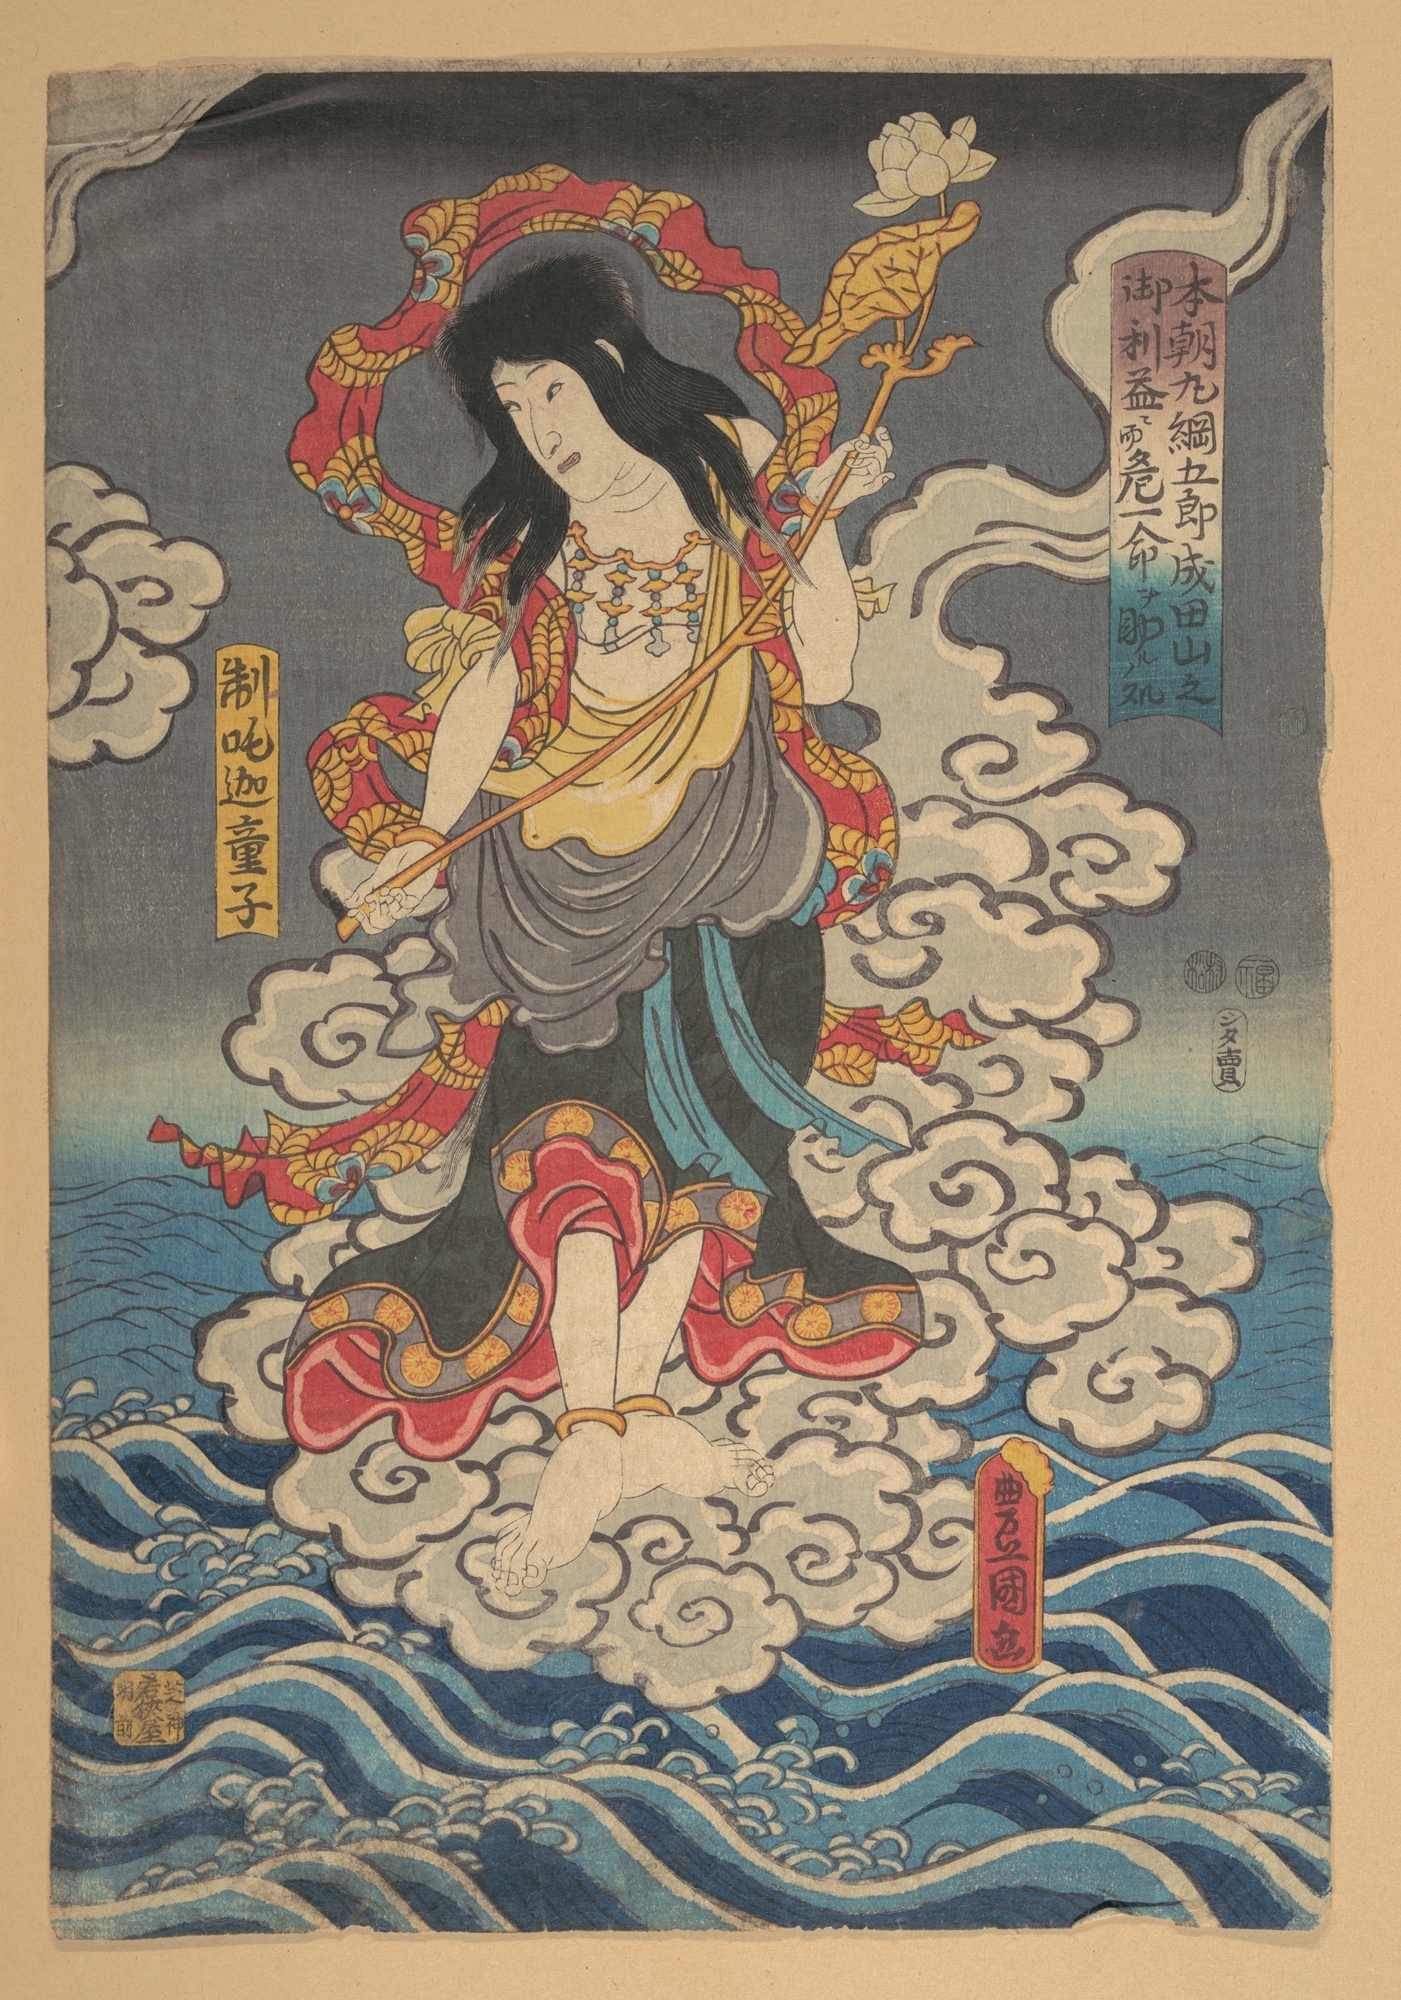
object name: print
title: Maruami Gorō Saved by Fudō's (Acala) Attendant Seitaka from Narita Shrine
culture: japanese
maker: utagawa kunisada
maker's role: artist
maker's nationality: japanese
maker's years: 1786-1864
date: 1801-1900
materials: ink, paper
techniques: woodblock print